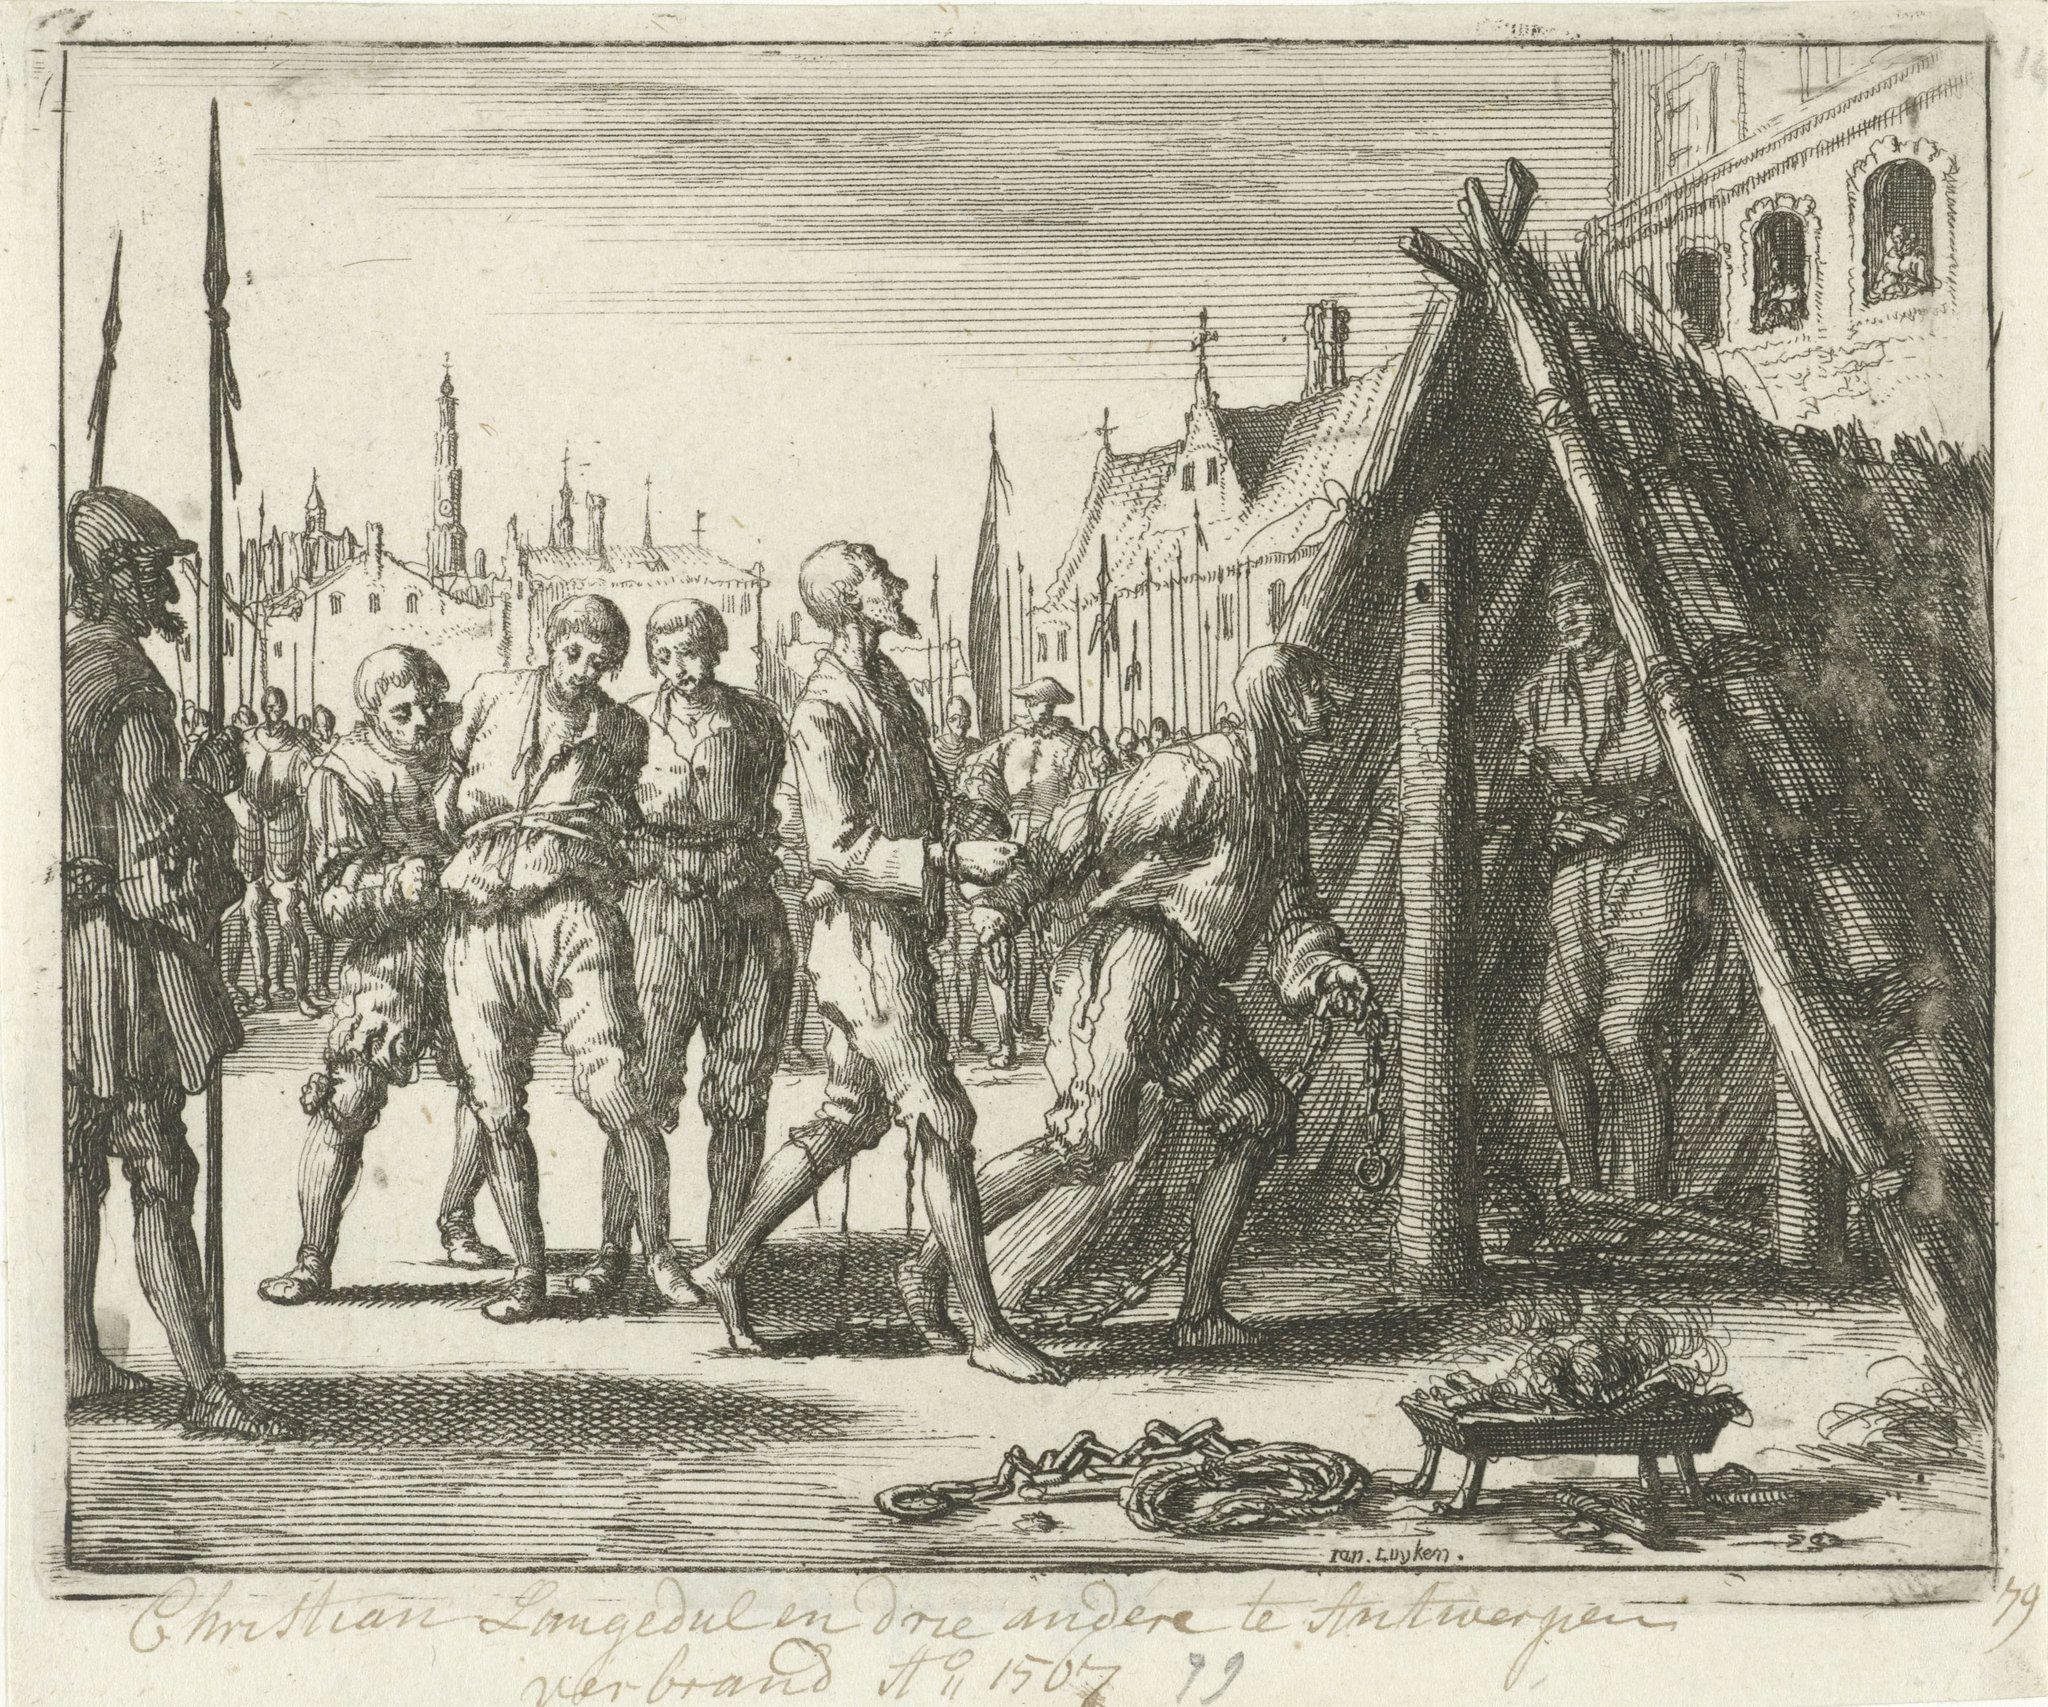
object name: print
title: Christiaan Langedul en drie anderen te Antwerpen voor de brandstapel, 1567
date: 1685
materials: paper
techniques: etching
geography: amsterdam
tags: execution of heretic, e.g. by burning at the stake, 'auto-da-fé', violent death by burning at the stake; pyre, antwerp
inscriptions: collector's mark: Lugt 2228, inscription: ‘Christian Langedul [...] Ao 1567’, number: ‘79’